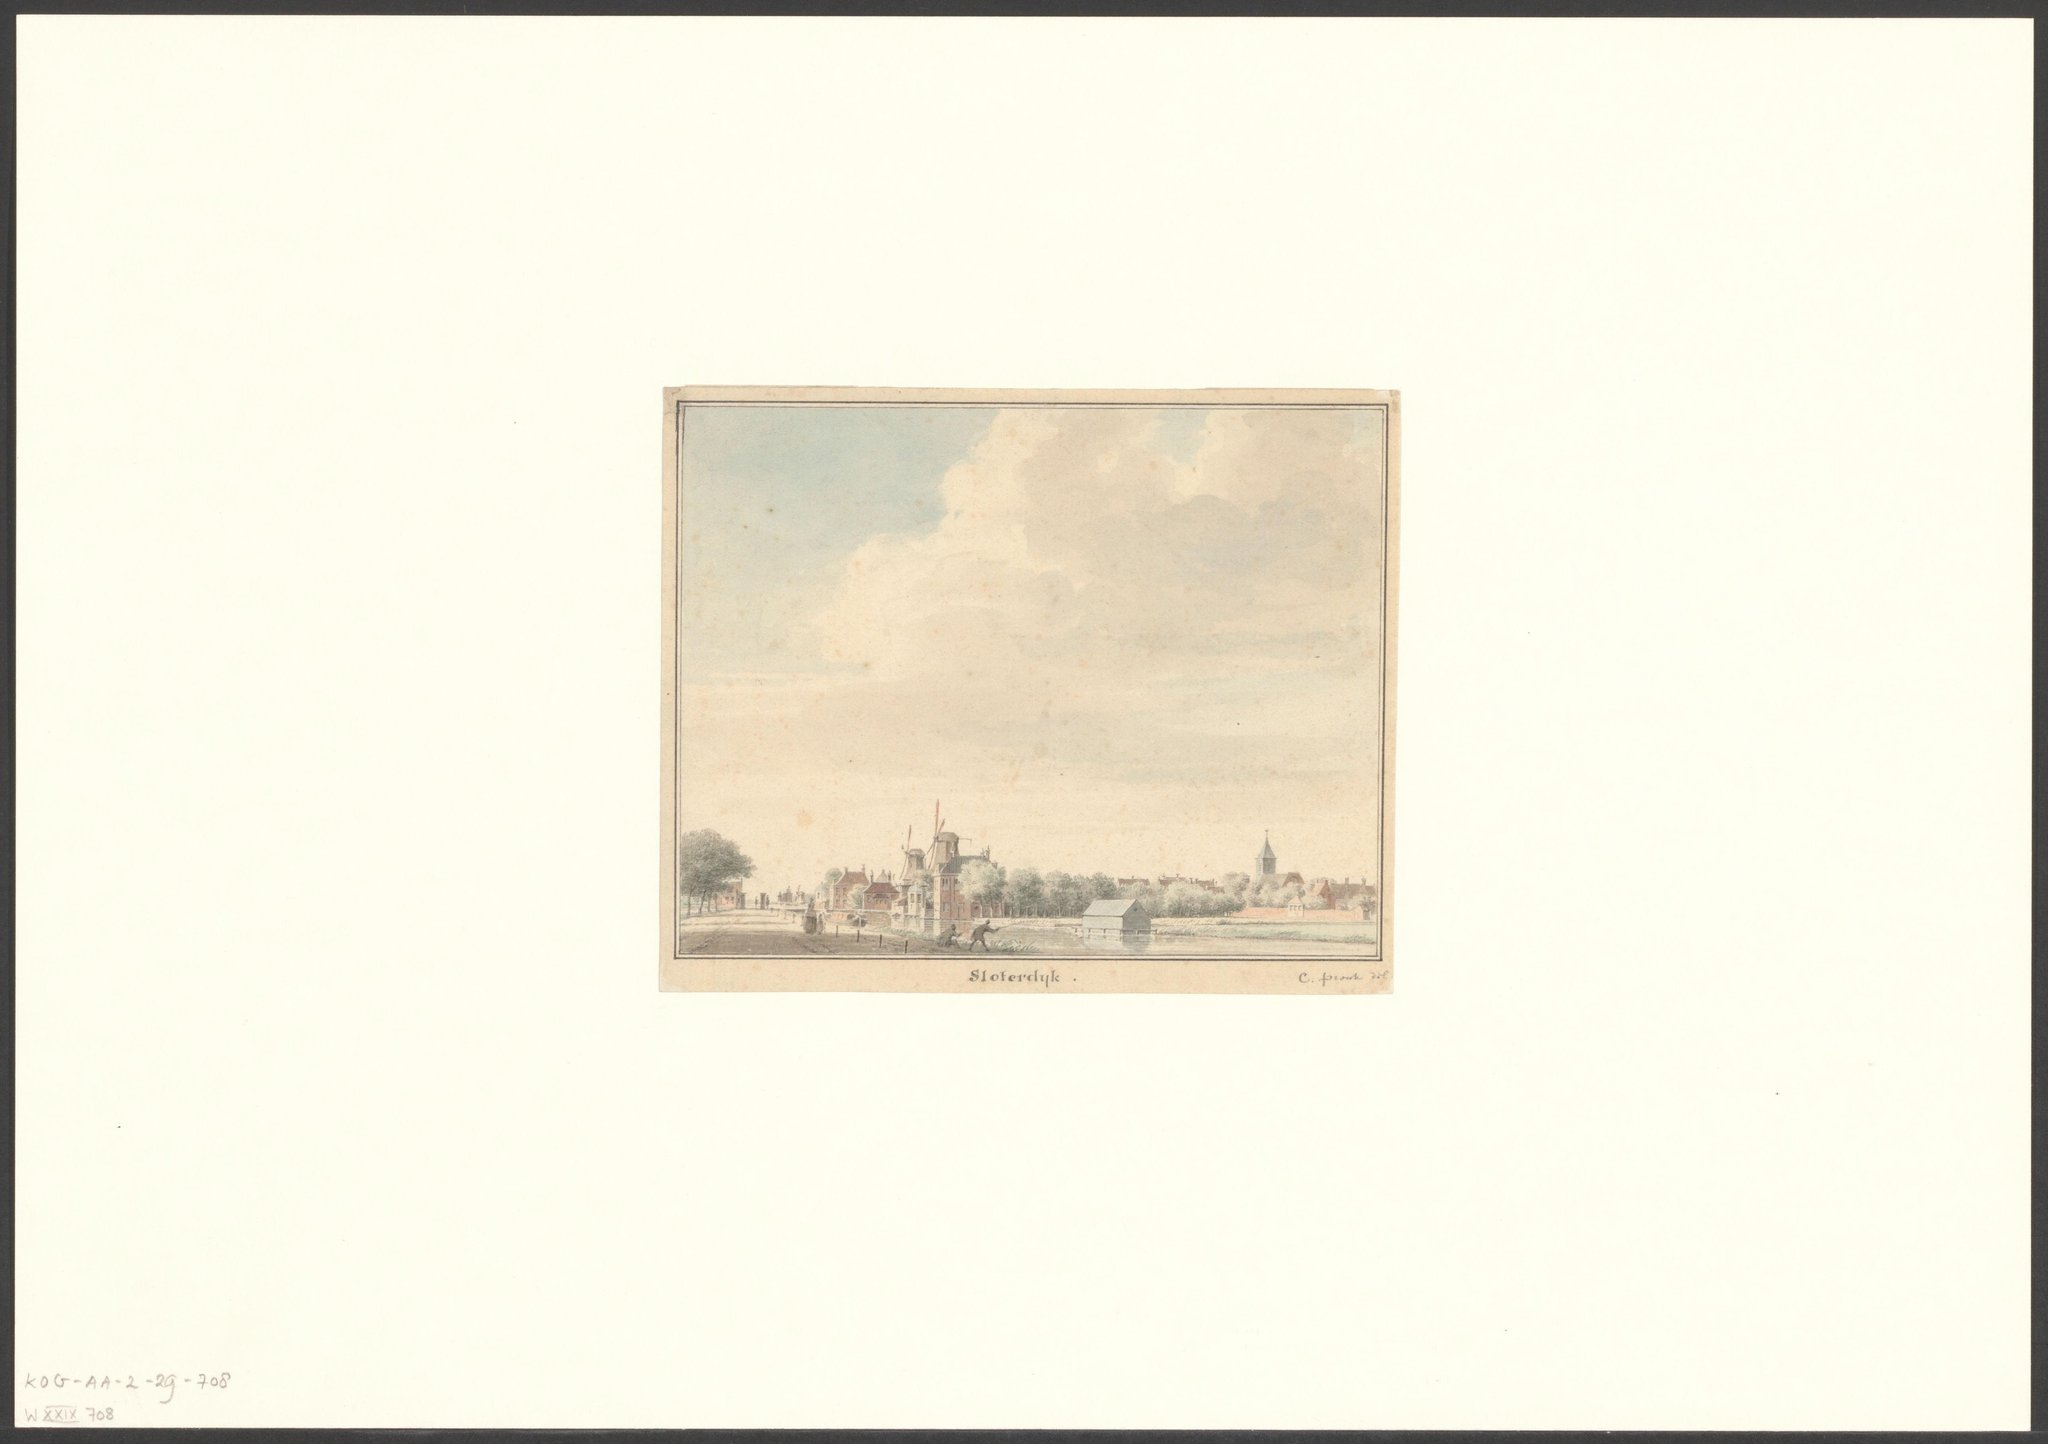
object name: drawing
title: Gezicht op de Haarlemmervaart gezien naar het tolhek bij Sloterdijk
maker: cornelis pronk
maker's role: draughtsman, painter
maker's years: 1691-1759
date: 1701-1759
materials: ink, paper, watercolor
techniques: brush, pen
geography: amsterdam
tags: city-view in general; 'veduta', canal, road, path, windmill in landscape, sloterdijk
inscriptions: signature: ‘C. pronk del’, collector's mark: Lugt 800a, inscription: ‘Sloterdijk’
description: Tekening binnen de Atlas Van Eck ingedeeld op wijknummer 29.